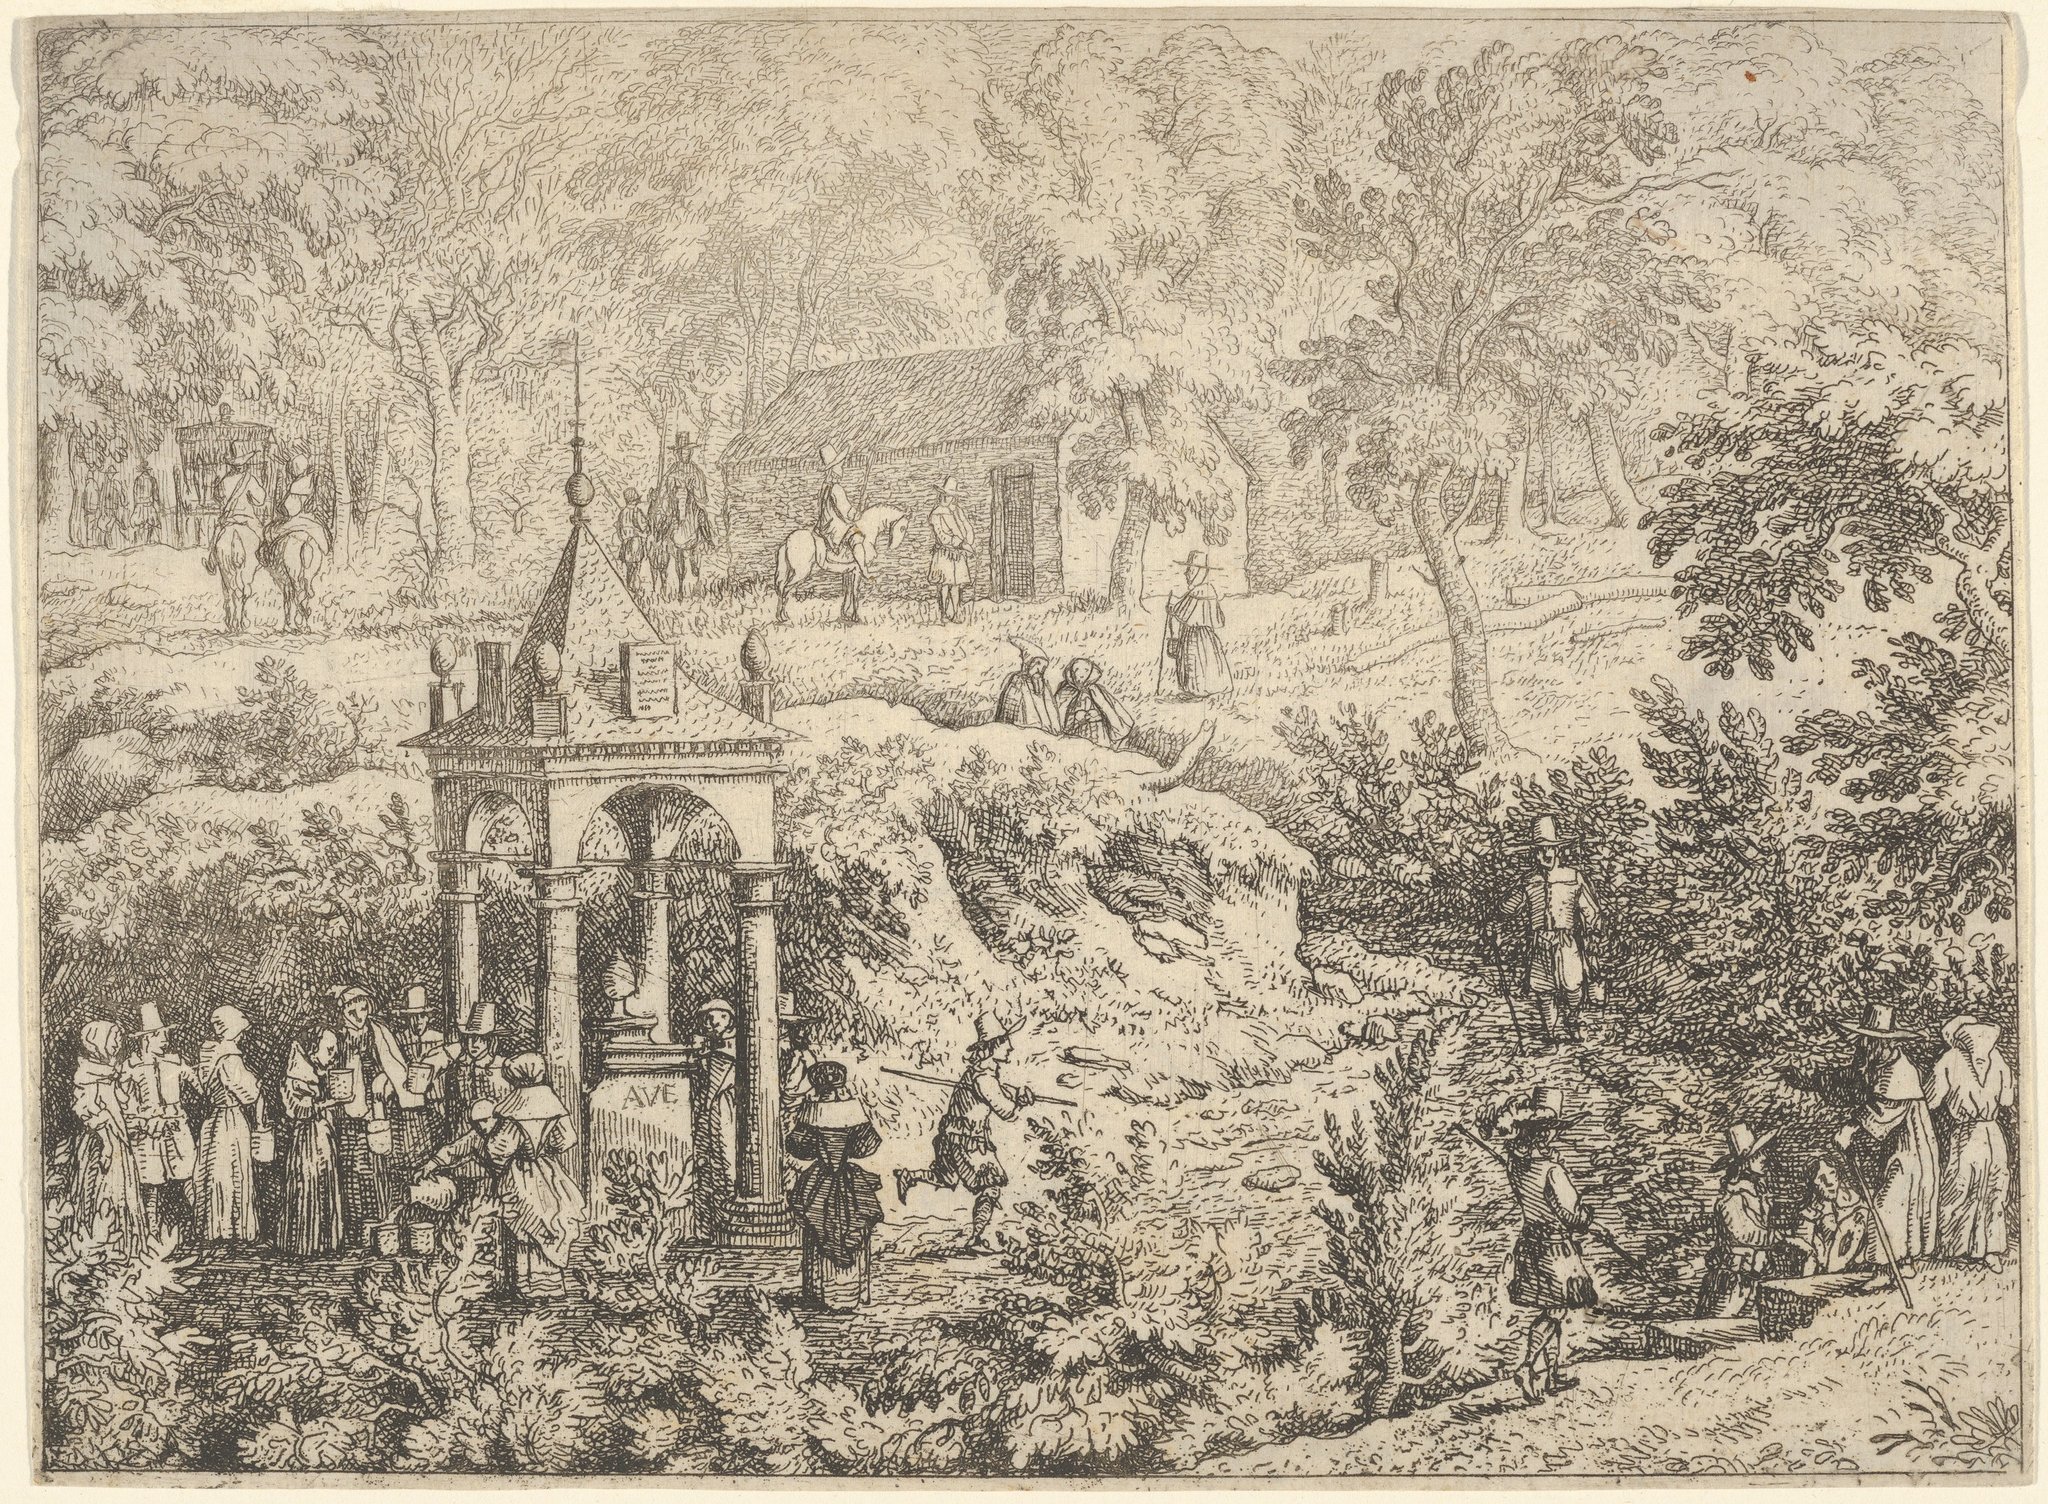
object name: print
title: The Third Spring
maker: allart van everdingen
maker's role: artist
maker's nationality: dutch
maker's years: 1621-1675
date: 1621-1675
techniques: engraving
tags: houses,horses